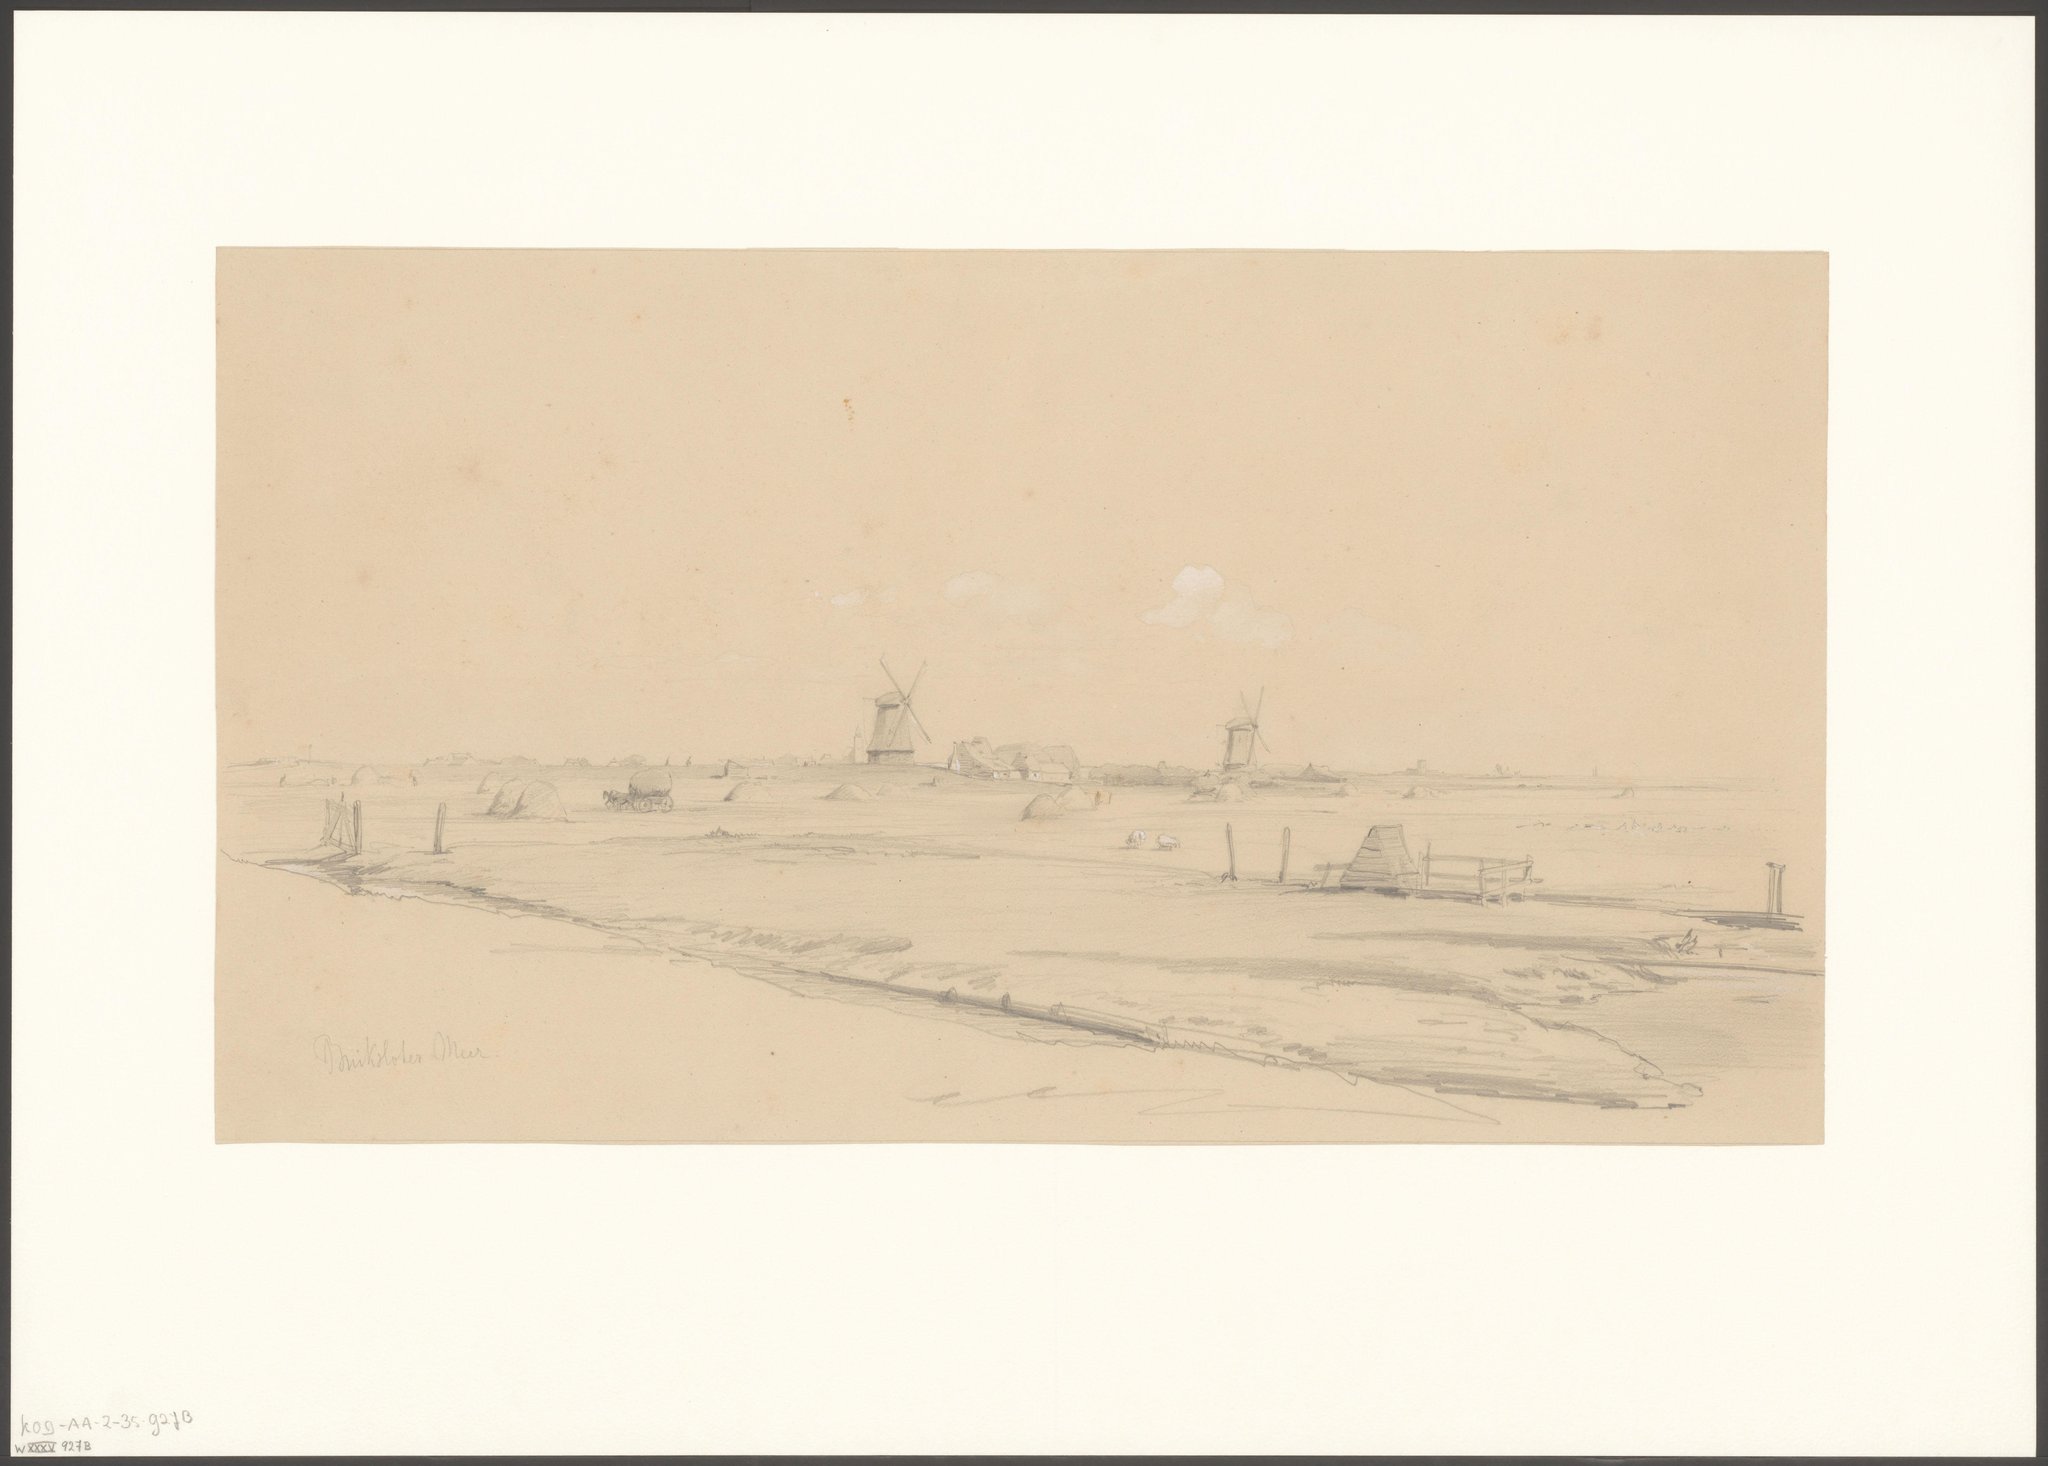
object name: drawing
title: Gezicht op het Buikslotermeer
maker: Anonymous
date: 1850-1950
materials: paint, paper, pencil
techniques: brush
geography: amsterdam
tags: village, lake, windmill in landscape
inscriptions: collector's mark: Lugt 800a, inscription: ‘Buiksloter Meer’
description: Tekening binnen de Atlas Van Eck ingedeeld op wijknummer 35.